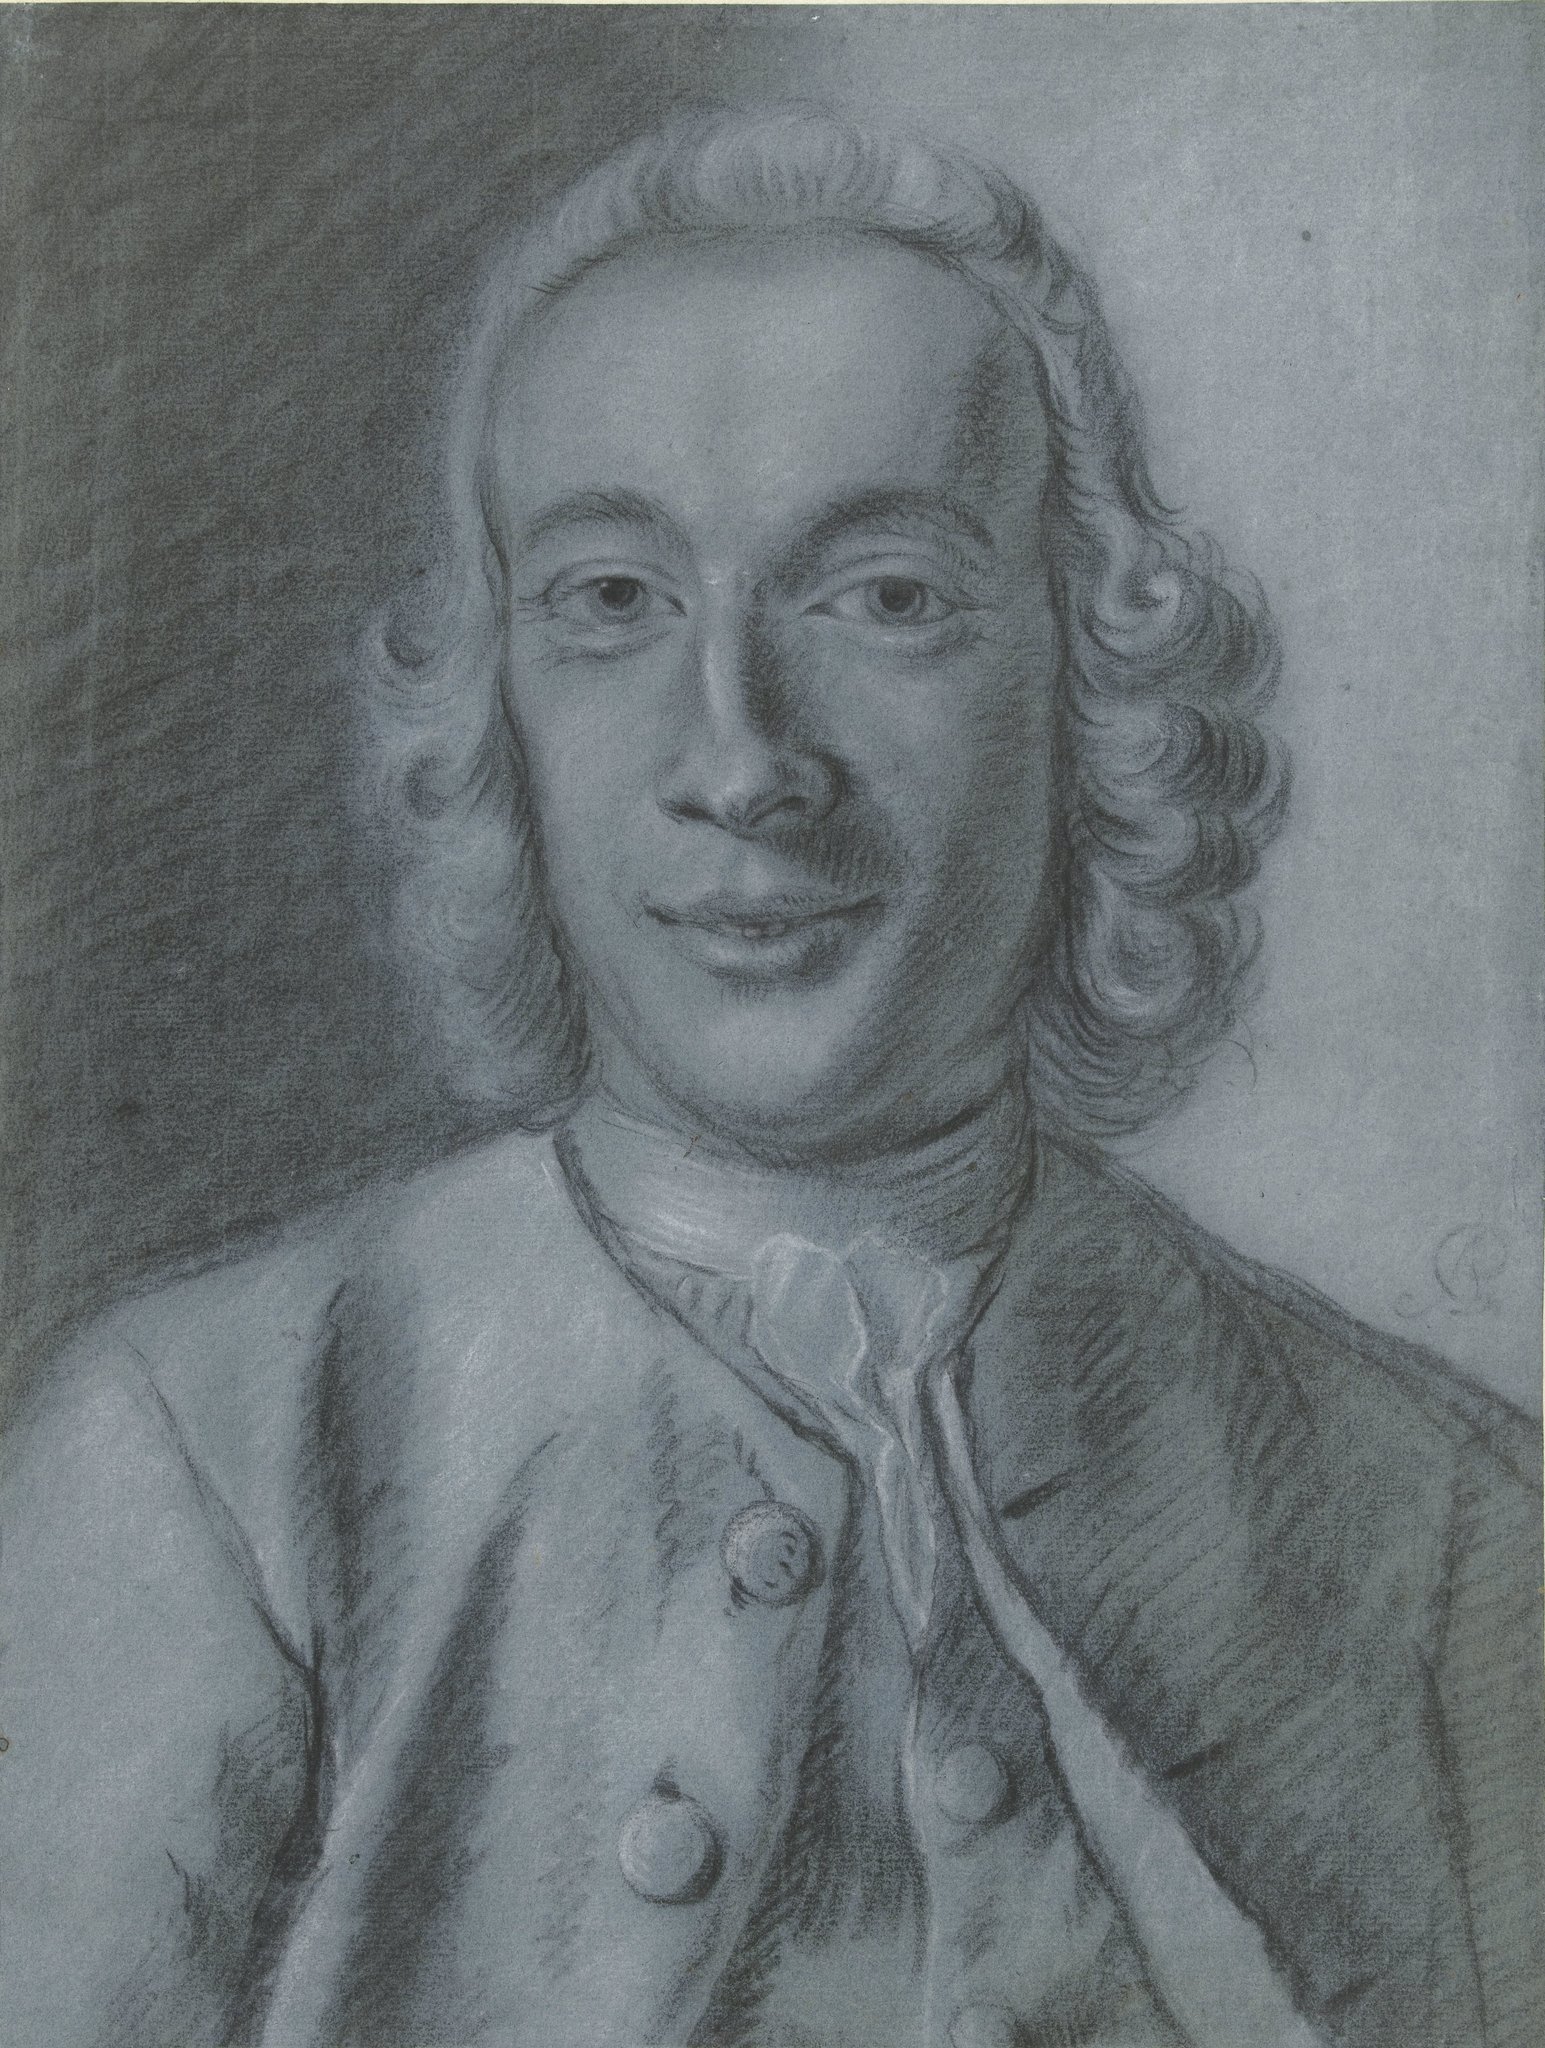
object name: drawing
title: Portret van een onbekende man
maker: jacob appel (i)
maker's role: draughtsman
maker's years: 1680-1751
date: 1690-1751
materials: chalk, paper